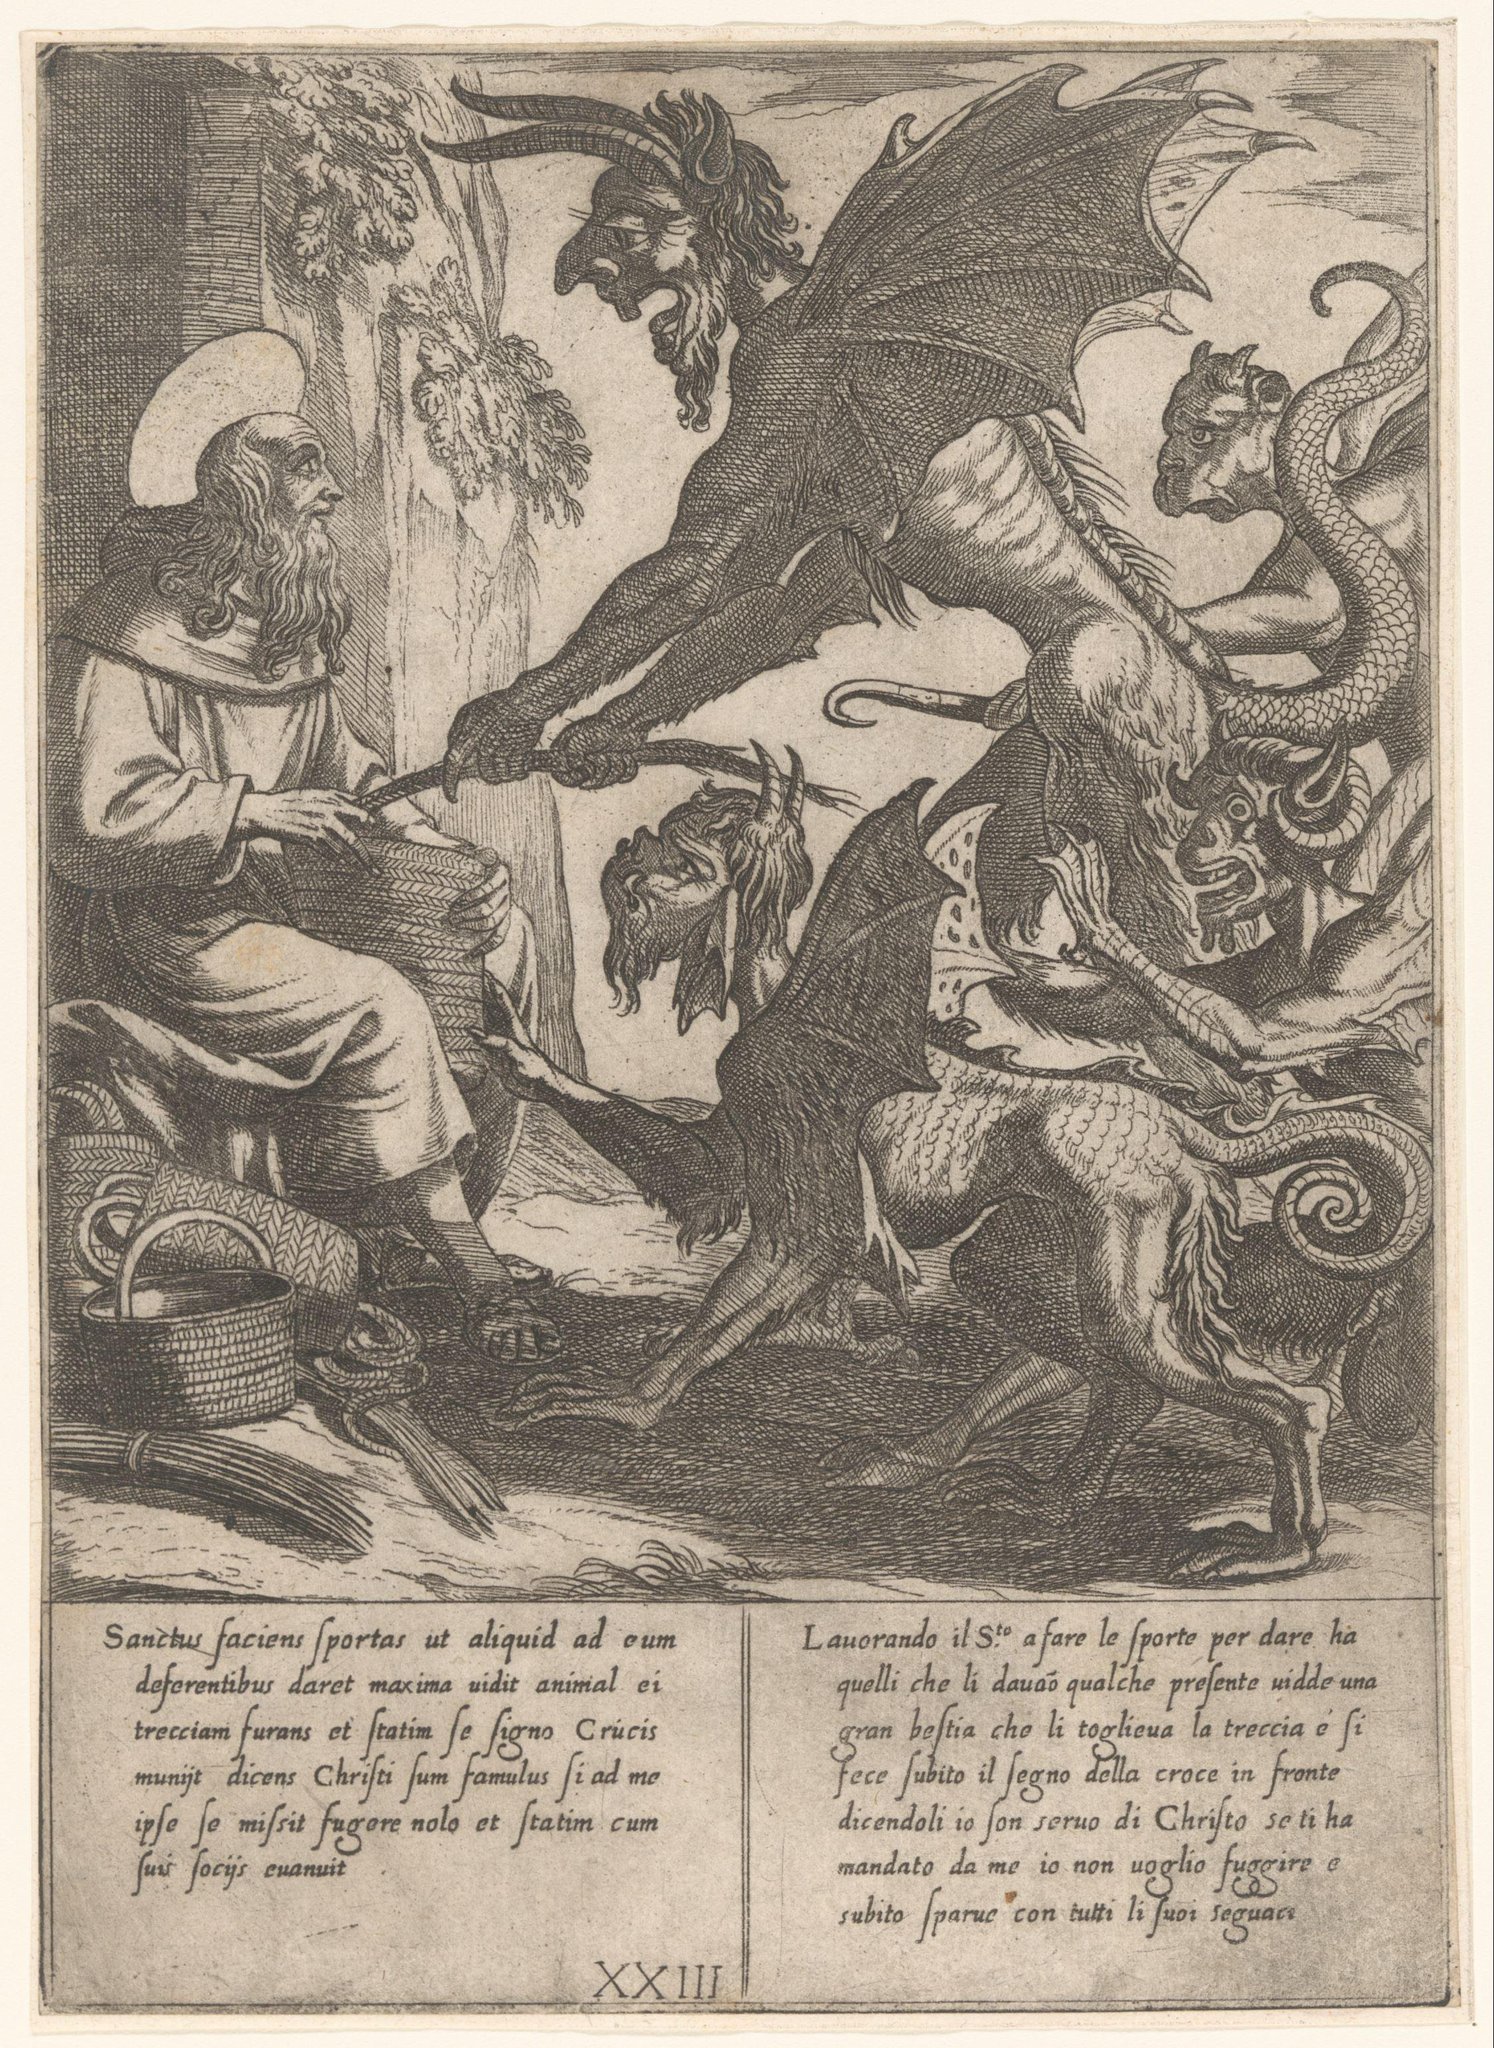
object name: print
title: Het leven van de heilige Antonius de Grote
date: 1598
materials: paper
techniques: etching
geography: italy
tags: devil(s) and demons, the hermit antony abbot (antonius abbas) of egypt, also called the great; possible attributes: bell, book, t-shaped staff, flames, pig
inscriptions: collector's mark: Lugt 240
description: Deze prent maakt deel uit van een reeks van 27 prenten (+ titelprent) over het leven van de heilige Antonius, naar een frescocyclus in de S. Antonio Abbate in Rome door Giovanni Battista Lombardelli en Niccolò Circignani.